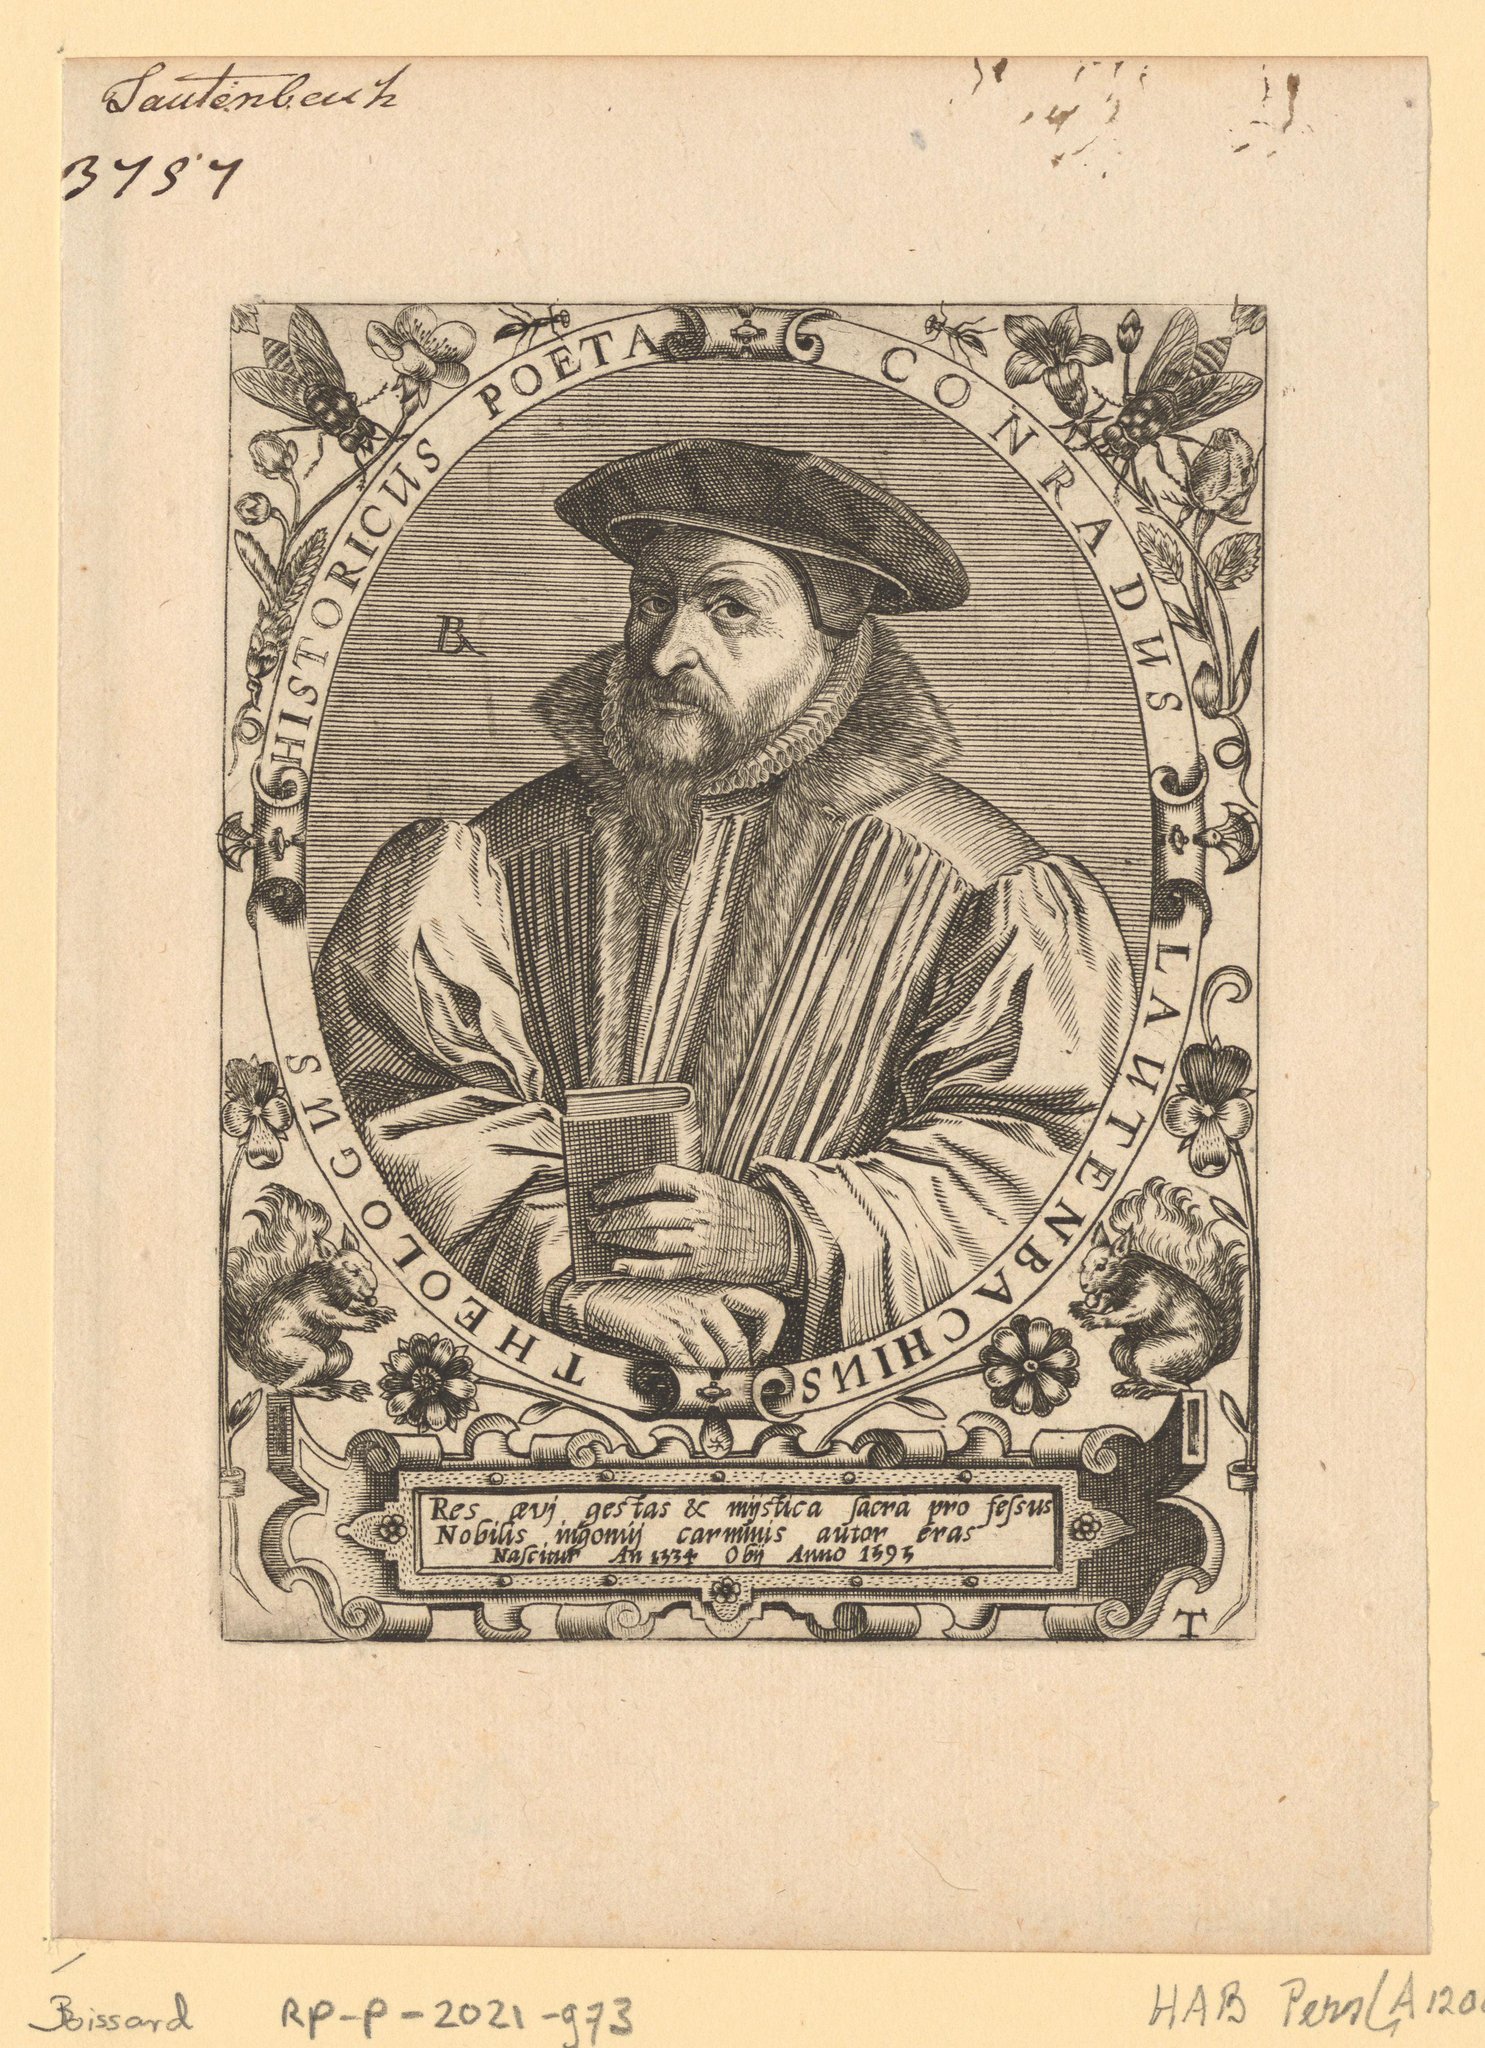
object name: book illustration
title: Bibliotheca chalcographica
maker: robert boissard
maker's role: print maker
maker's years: 1570-1611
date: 1650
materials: paper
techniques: engraving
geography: france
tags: insects: ant, theologian, rodents: squirrel - ff fabulous animals (sometimes wrongly called 'grotesques'); 'mostri' (ripa), historical persons, ornament ~ cartouche, insects: fly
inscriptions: inscription: ‘Lautenbach’, number: ‘3787’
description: Prent voor het eerst (zonder nummering) verschenen in: Boissard, Jean Jacques. Icones quinquaginta virorum illustrium doctrina & eruditione praestantium ad vivum effictae. Frankfurt am Main: s.n., 1597. De prent is daarna mogelijk nog gebruikt voor Bibliotheca sive thesaurus (...), 1628, en in deze staat in ieder geval voor het eerste deel van 'Bibliotheca chalcographica', 1650.